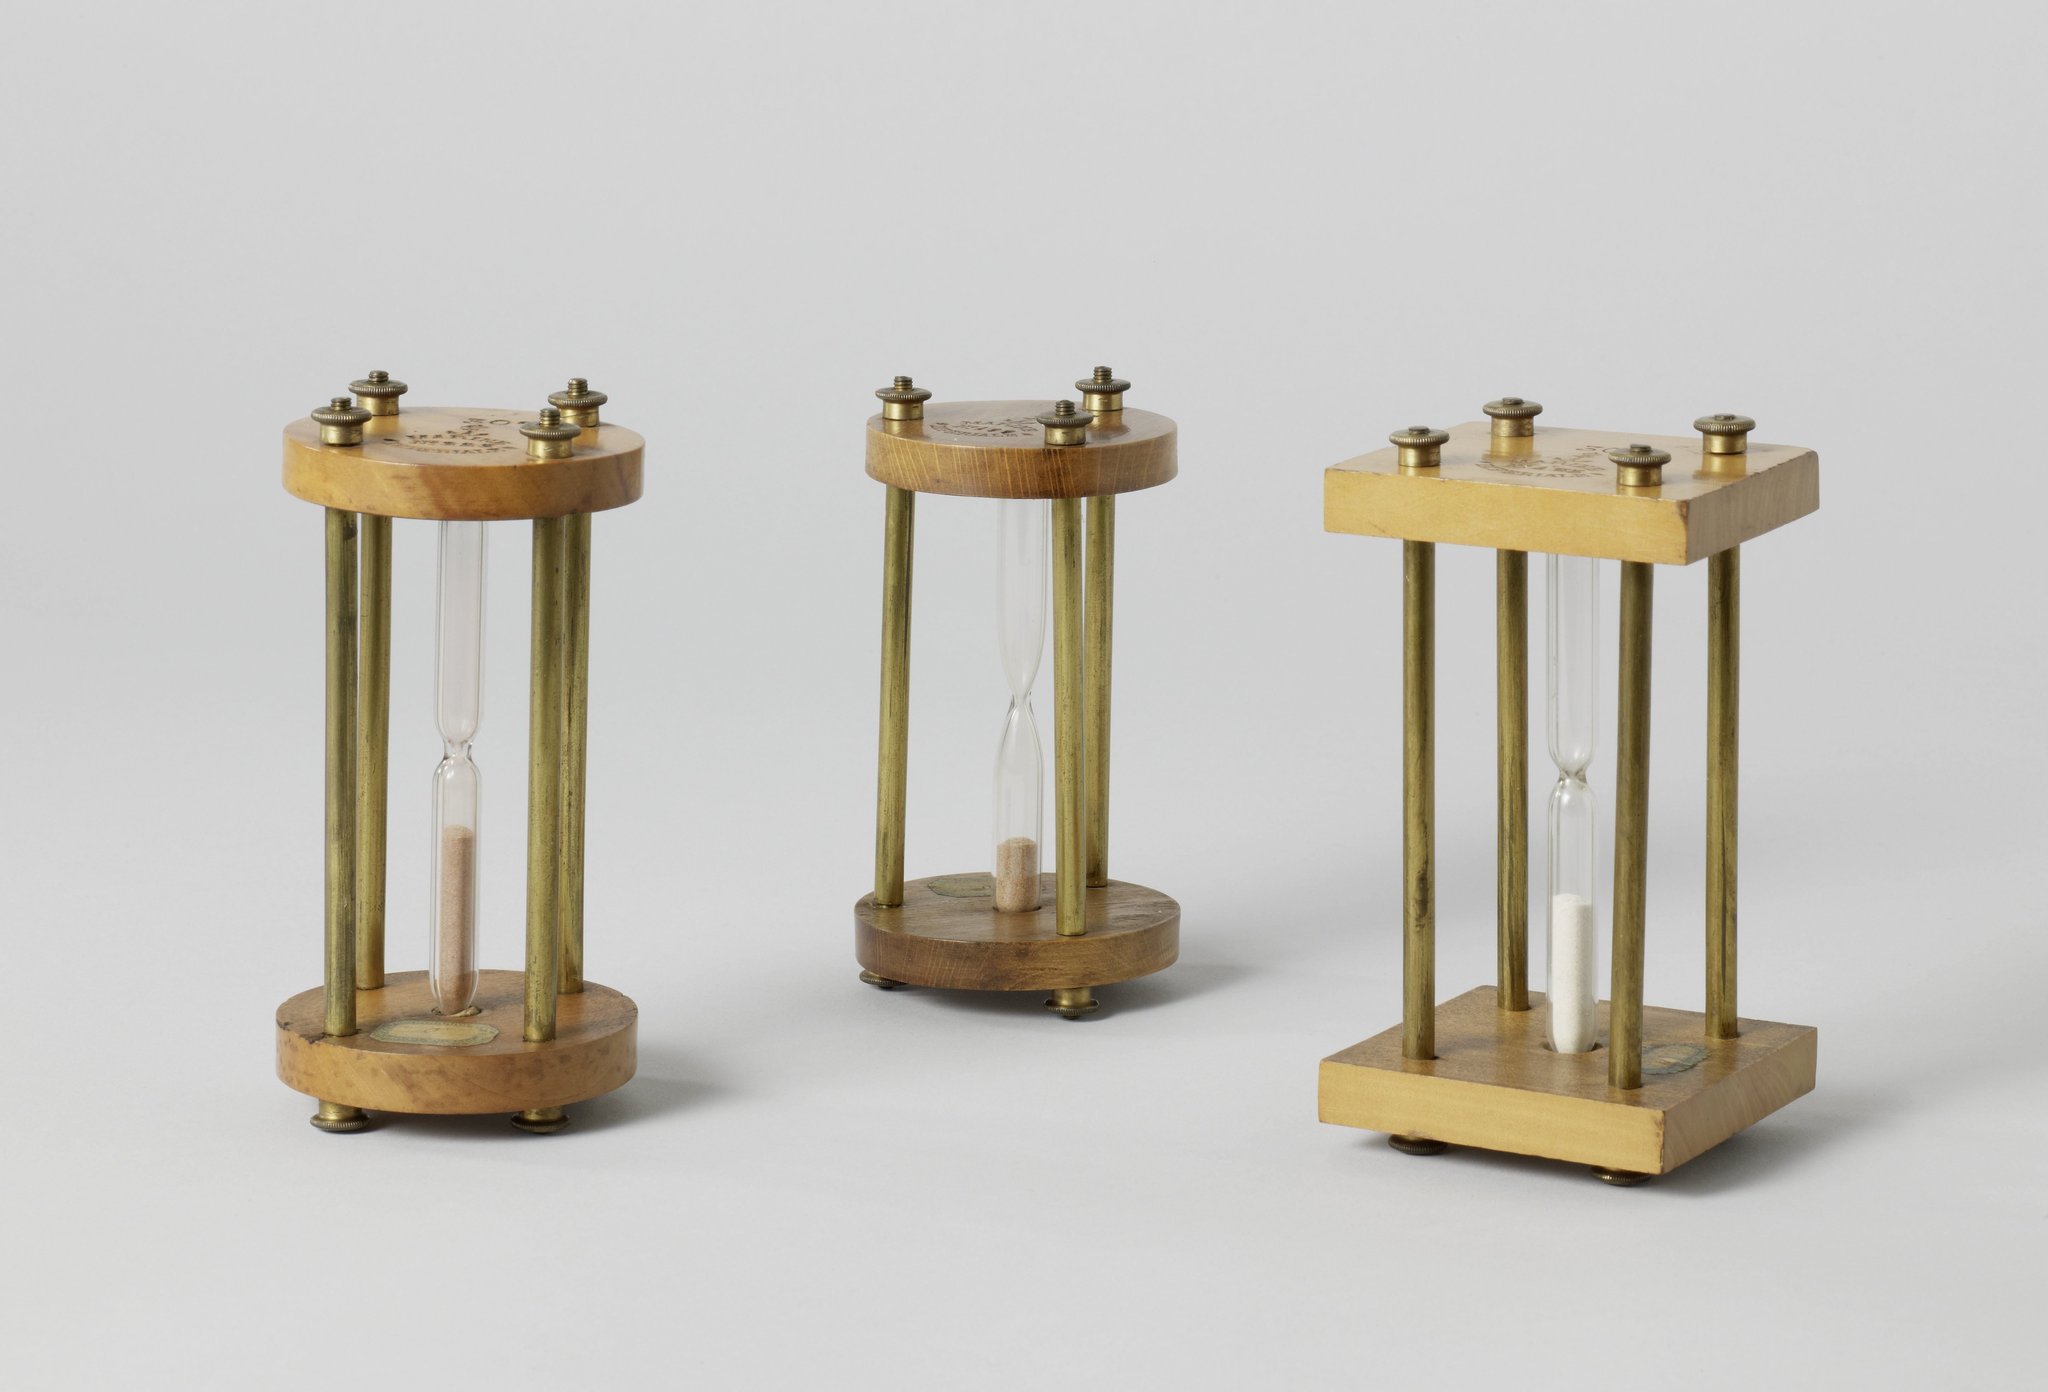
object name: sand glass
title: Three Sand Glasses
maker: Anonymous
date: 1860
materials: brass, cork, glass, mineral, wood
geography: france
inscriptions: inscription, on model 3, on the top: ‘30 S / MARINE / Nº 425 / IMPERIALE’, inscription, on model 2, on the top: ‘30 S / MARINE / Nº 223 / IMPERIALE’, inscription, on model 1, on the top: ‘15 S / MARINE / Nº 199 / IMPERIALE’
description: In totaal werden vier logglazen in 1862 door de heer De la Marche, hydrografisch ingenieur van de Franse Marine, aan de Nederlandse Marine aangeboden; een glas van 15 seconden is verloren.